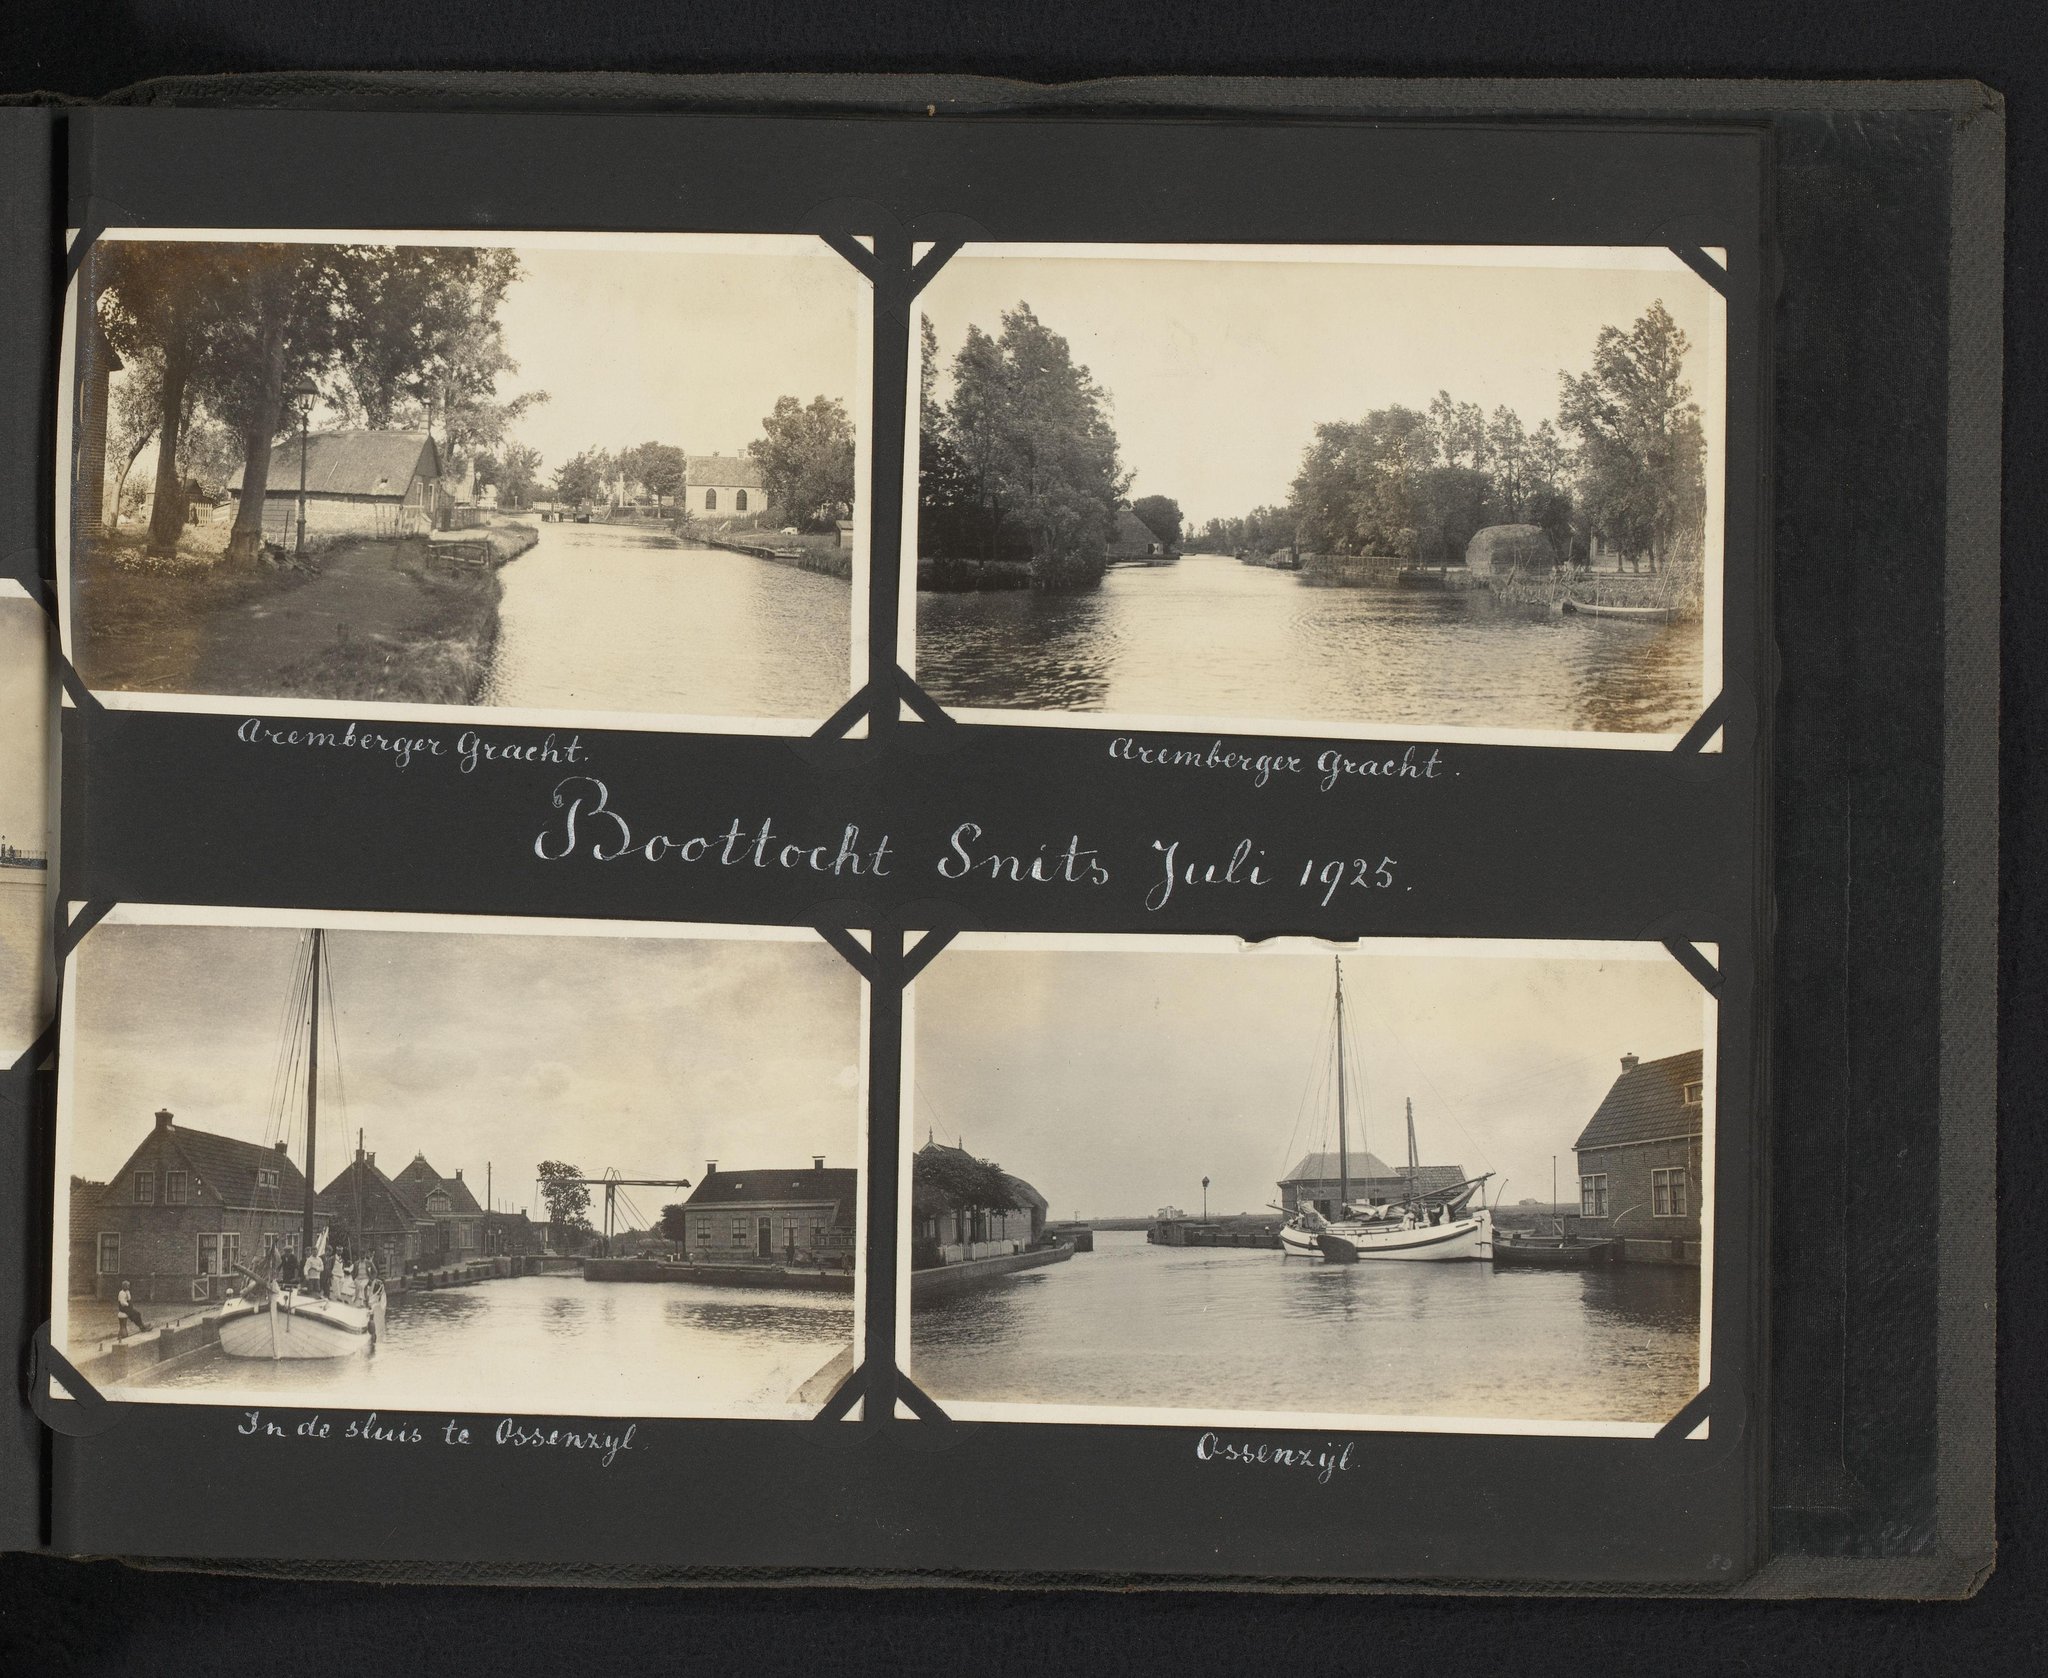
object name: photograph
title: Vier foto's van een boottocht met zeilboot de Snits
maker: hendrik herman van den berg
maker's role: amateurfotograaf, jurist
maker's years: 1875-1944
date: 1907-1925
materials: paper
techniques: gelatin silver print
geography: overijssel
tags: sailing-ship, sailing-boat, canal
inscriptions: inscription: ‘In de sluis te Ossenzijl’, inscription: ‘Aremberger Gracht’, inscription: ‘Aremberger Gracht’, inscription: ‘Ossenzijl’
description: Deze foto's maken deel uit van een album.